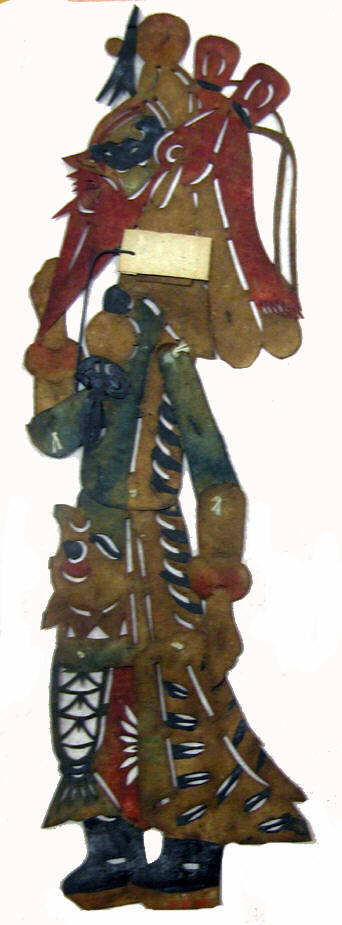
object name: shadow player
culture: chinese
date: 1801-1900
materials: cord, skin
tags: human figures